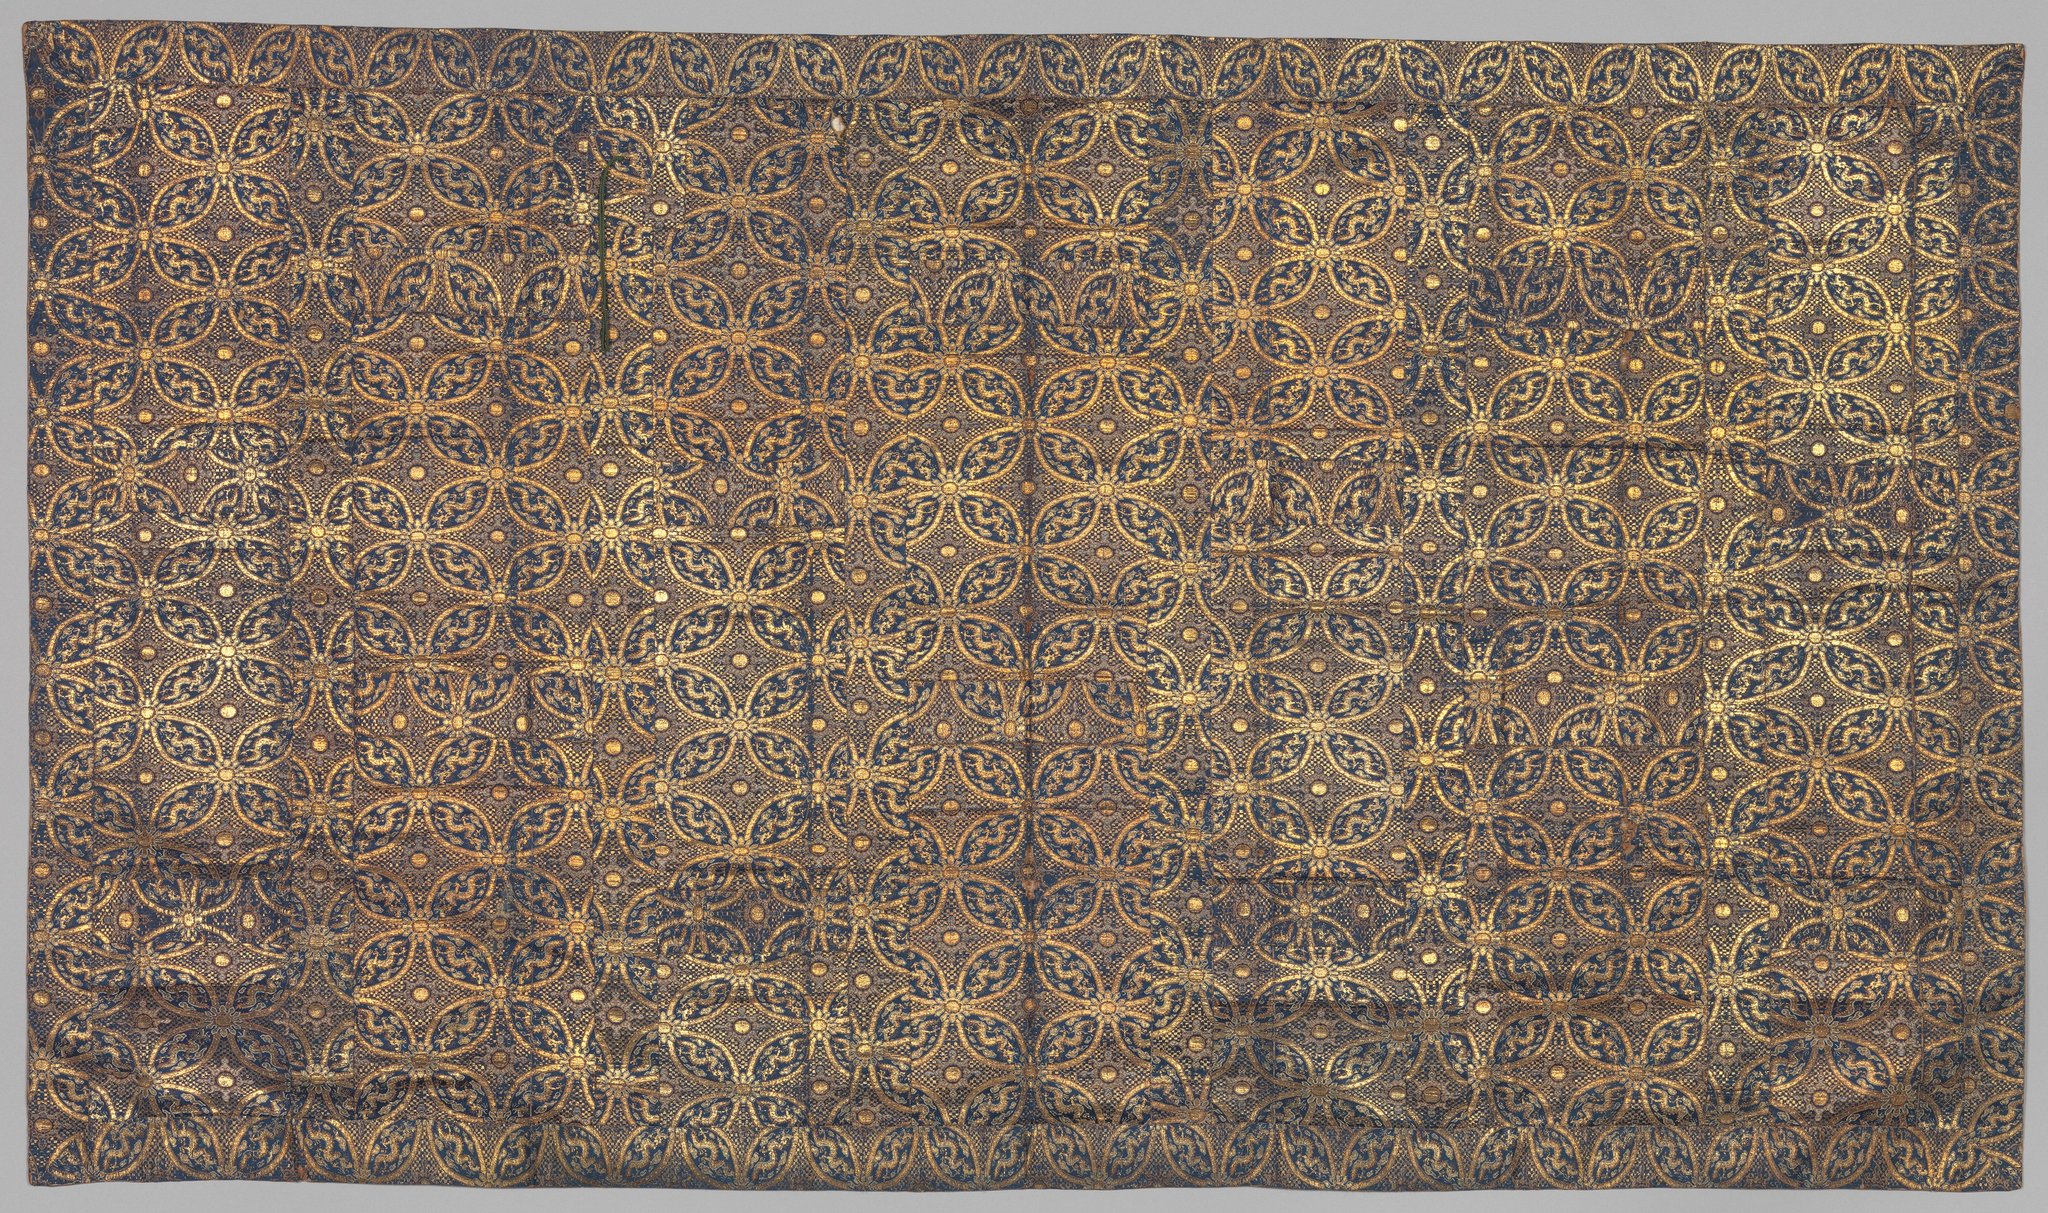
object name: robe, priest's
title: Buddhist Vestment (Kesa)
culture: japanese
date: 1701-1800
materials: metal thread, silk